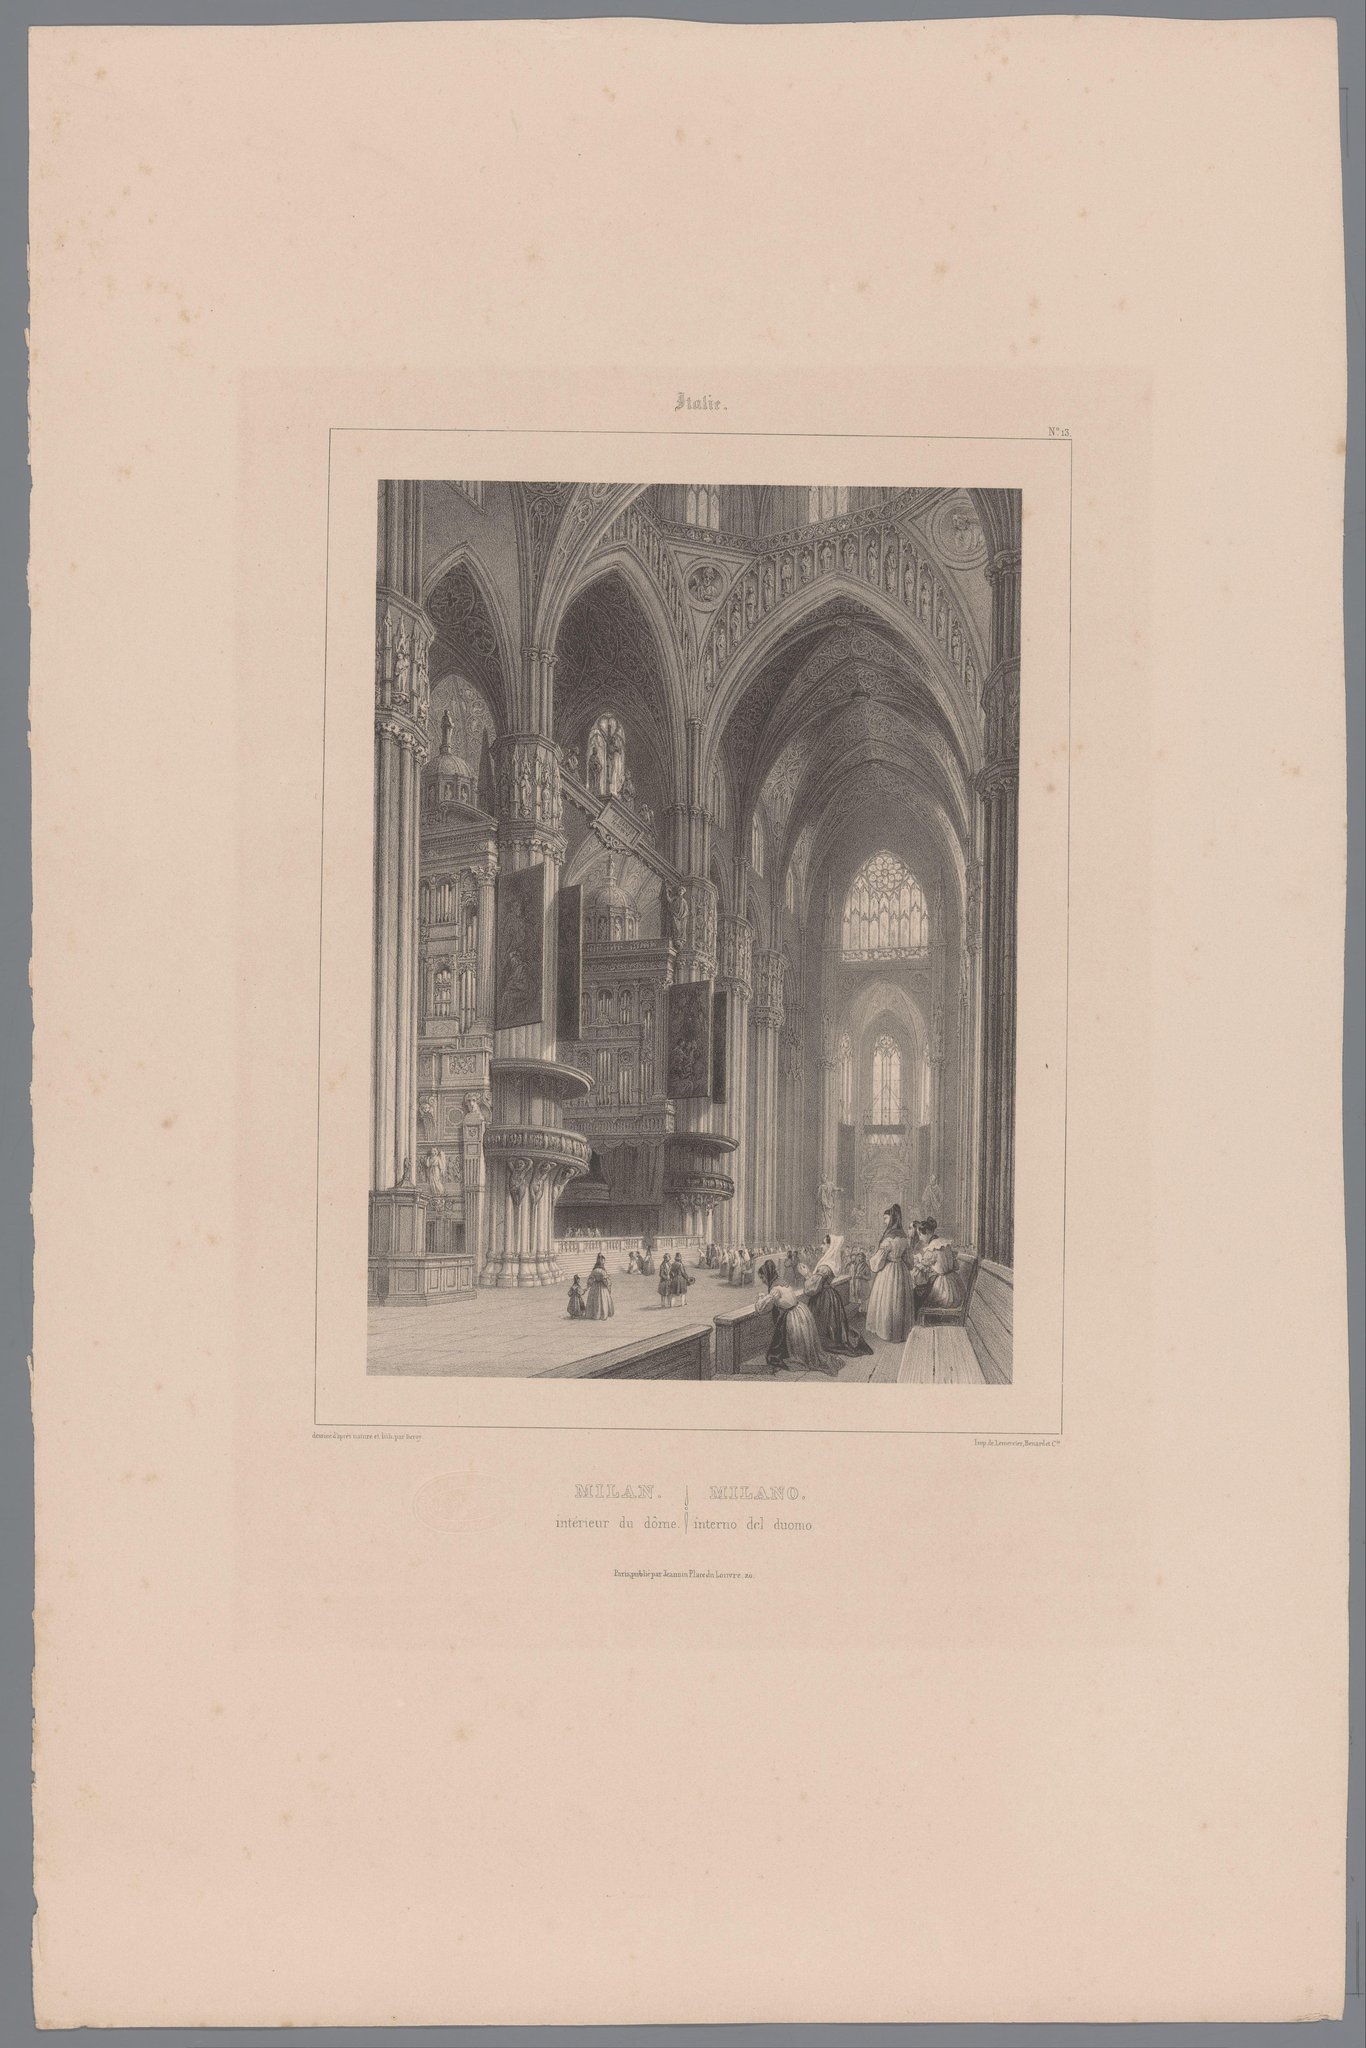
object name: print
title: Gezichten in Pavia, Monza en Milaan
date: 1838-1841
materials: paper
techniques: lithograph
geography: paris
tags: interior of church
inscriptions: check stamp: Lugt 1397c, collector's mark: Lugt 2228a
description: Prent maakt deel uit van een omslag met zes prenten.